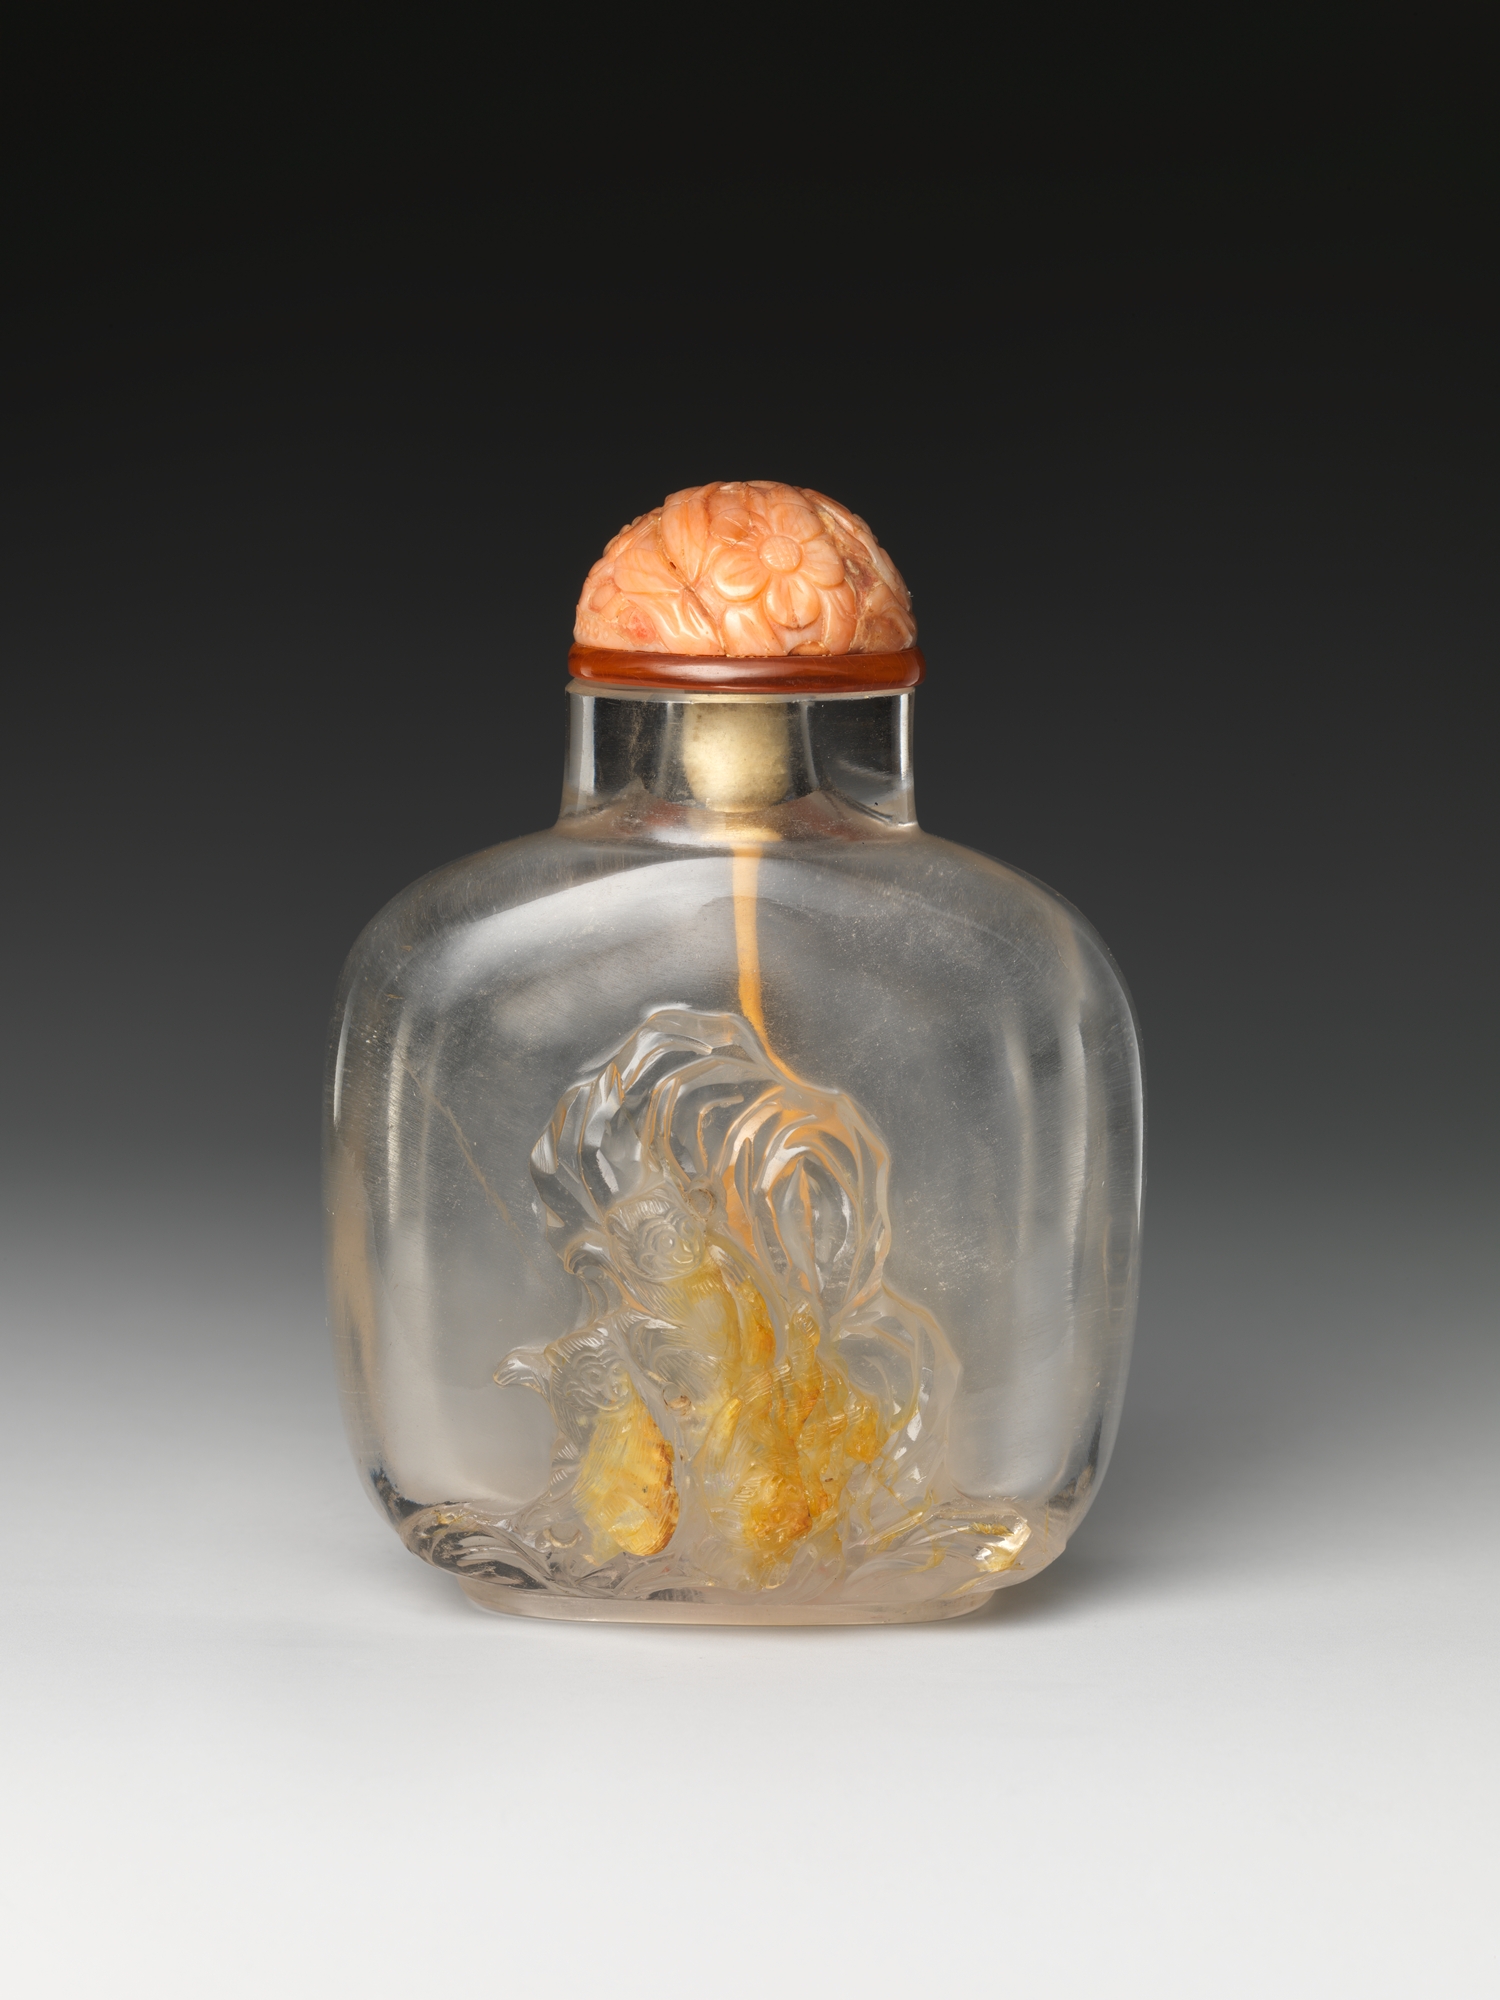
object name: snuff bottle with stopper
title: Snuff Bottle with Two Monkeys and Rock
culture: chinese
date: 1767-1833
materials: coral, quartz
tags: monkeys